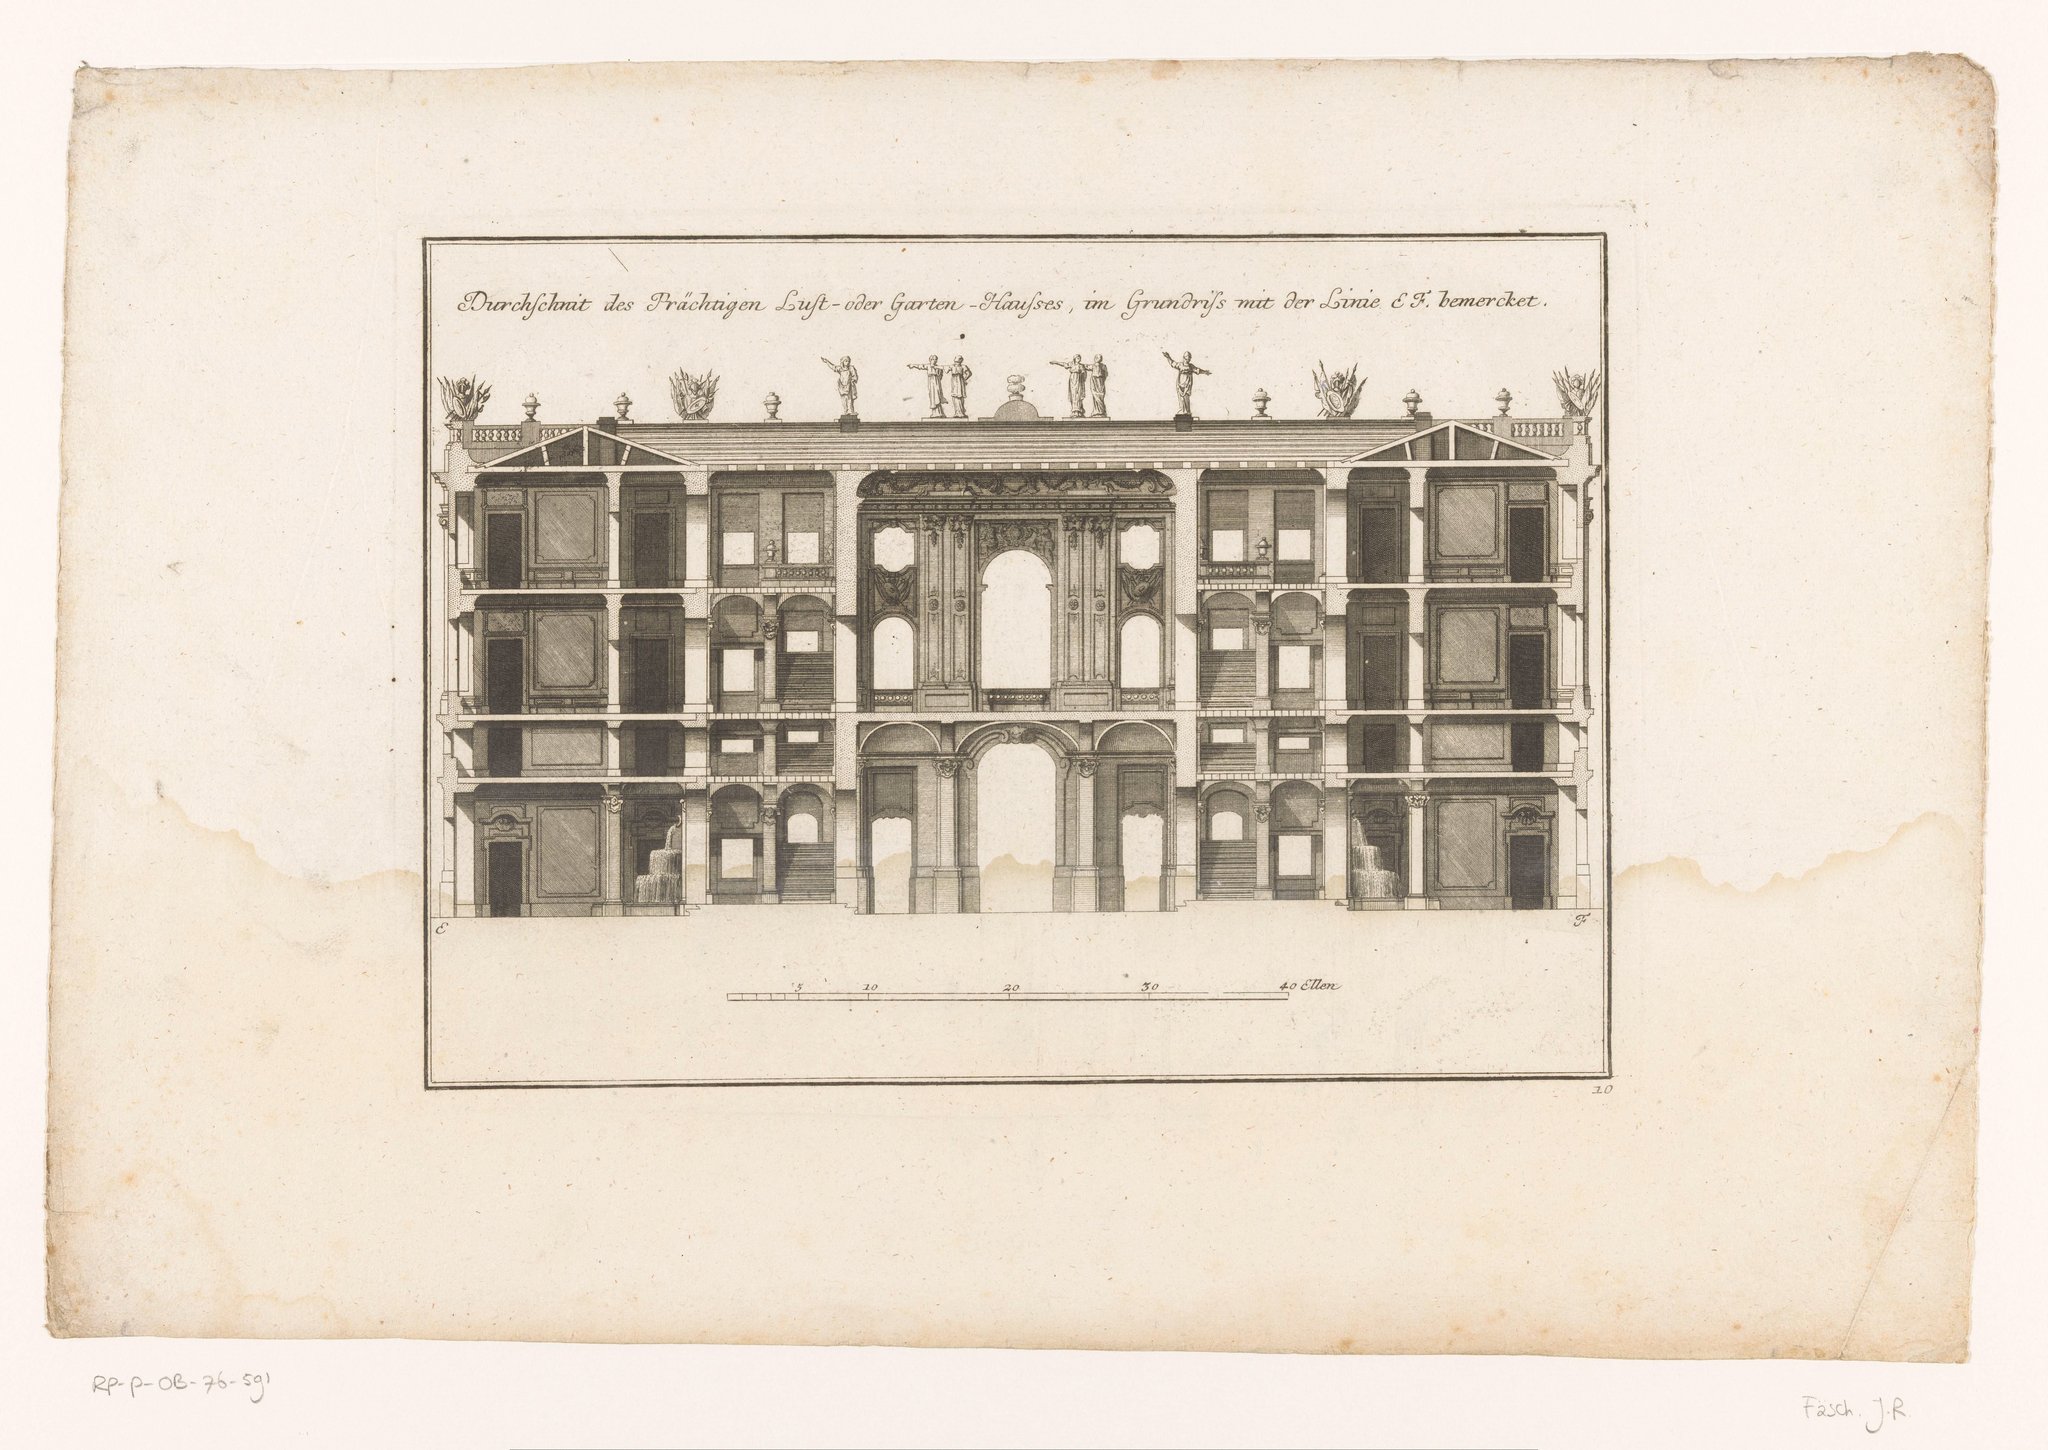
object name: ornament print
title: Joh. Rudolph Fäsches (...) Anderen Versuchs Fünffter Theil Sr. Architecton: Wercke bestehend in allerhand Grund-Haupt-Rissen u: Profilen unterschiedener gebäude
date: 1729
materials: paper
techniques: engraving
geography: nuremberg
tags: summer-house, arbour, garden-house (dutch: 'theekoepel'), section ~ architectural design or model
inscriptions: collector's mark: Lugt 2228